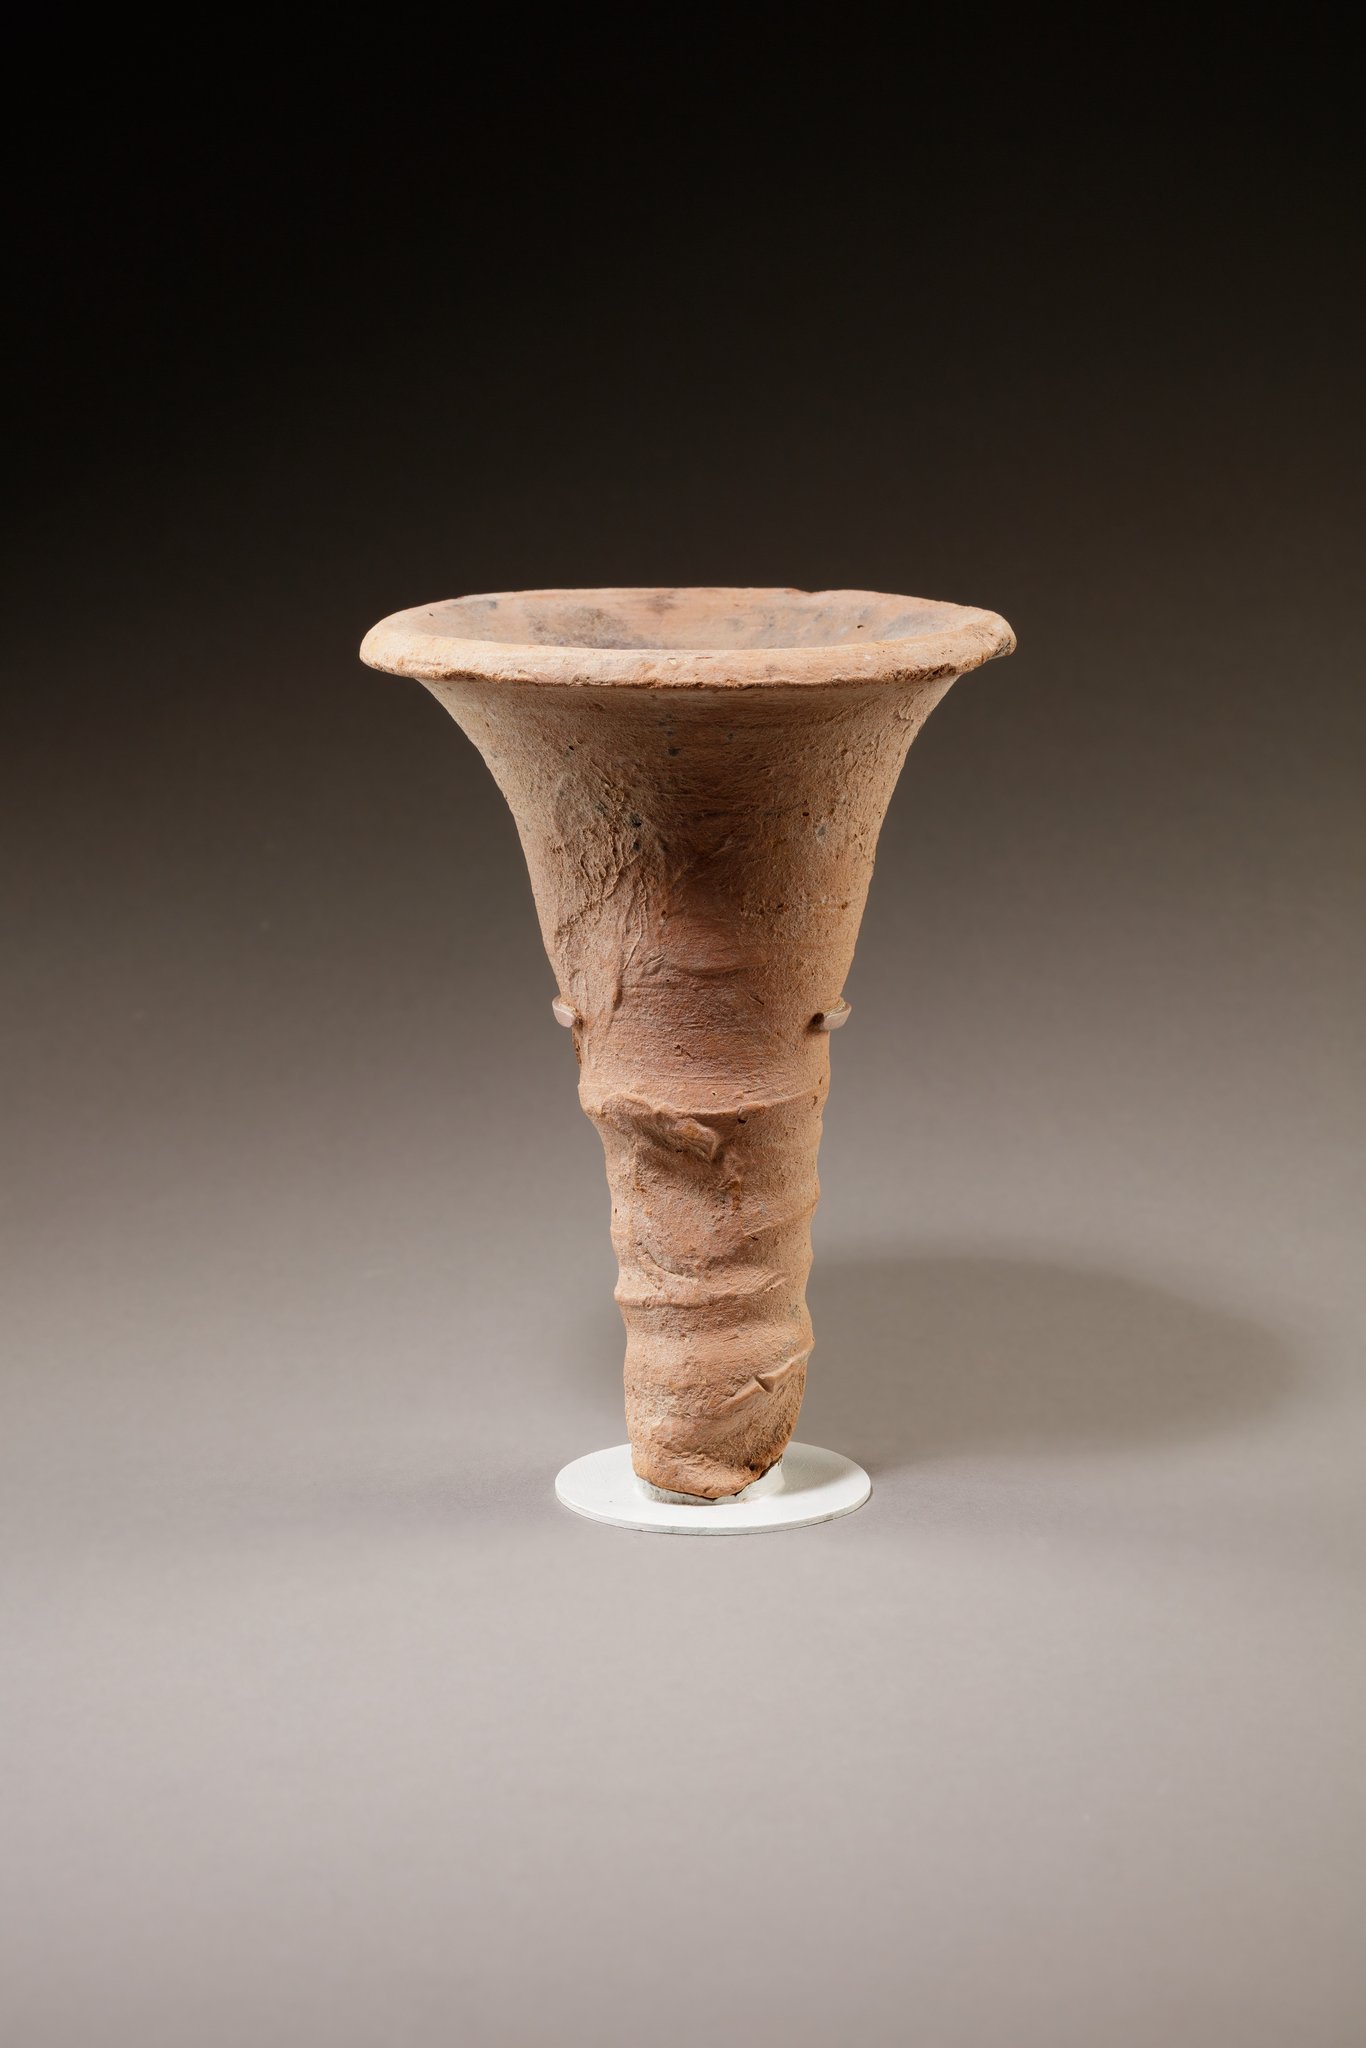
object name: torch holder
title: Torch-holder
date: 332-330 BCE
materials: pottery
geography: egypt